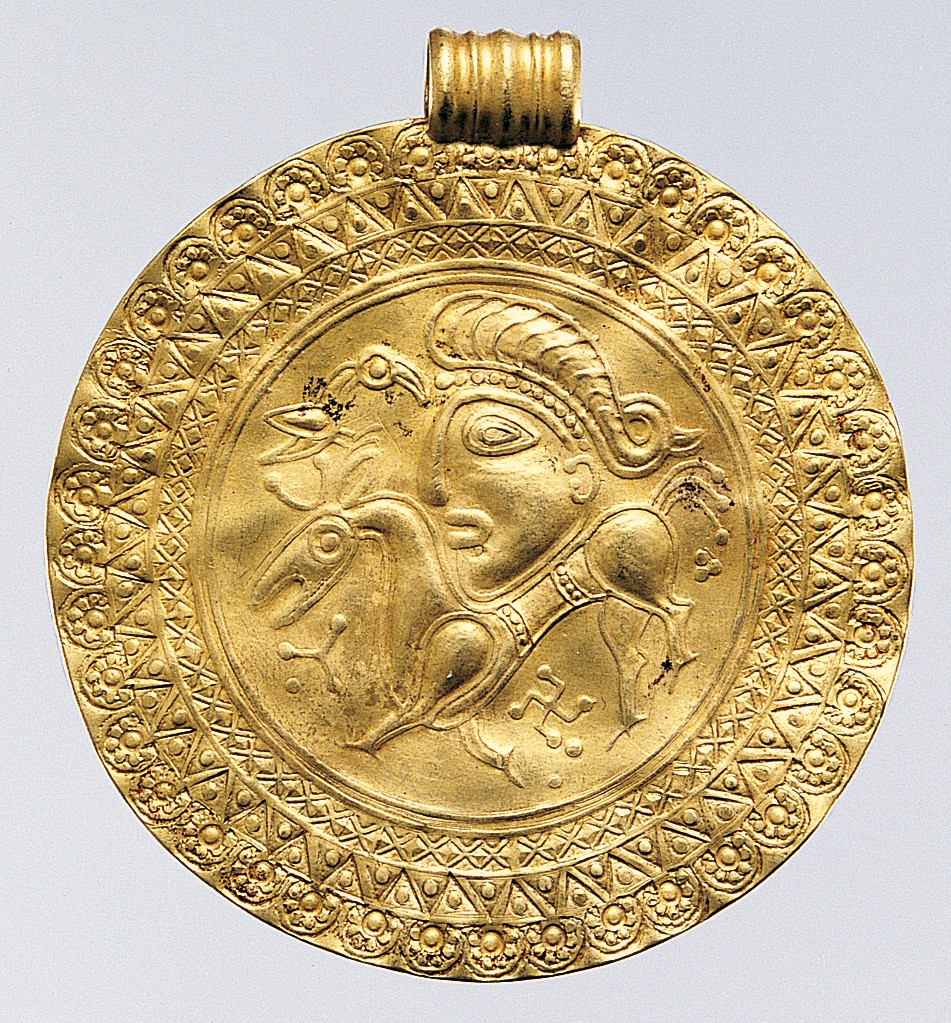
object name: bracteate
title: Gold Bracteate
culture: scandinavian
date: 400-600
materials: gold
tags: animals,birds,faces